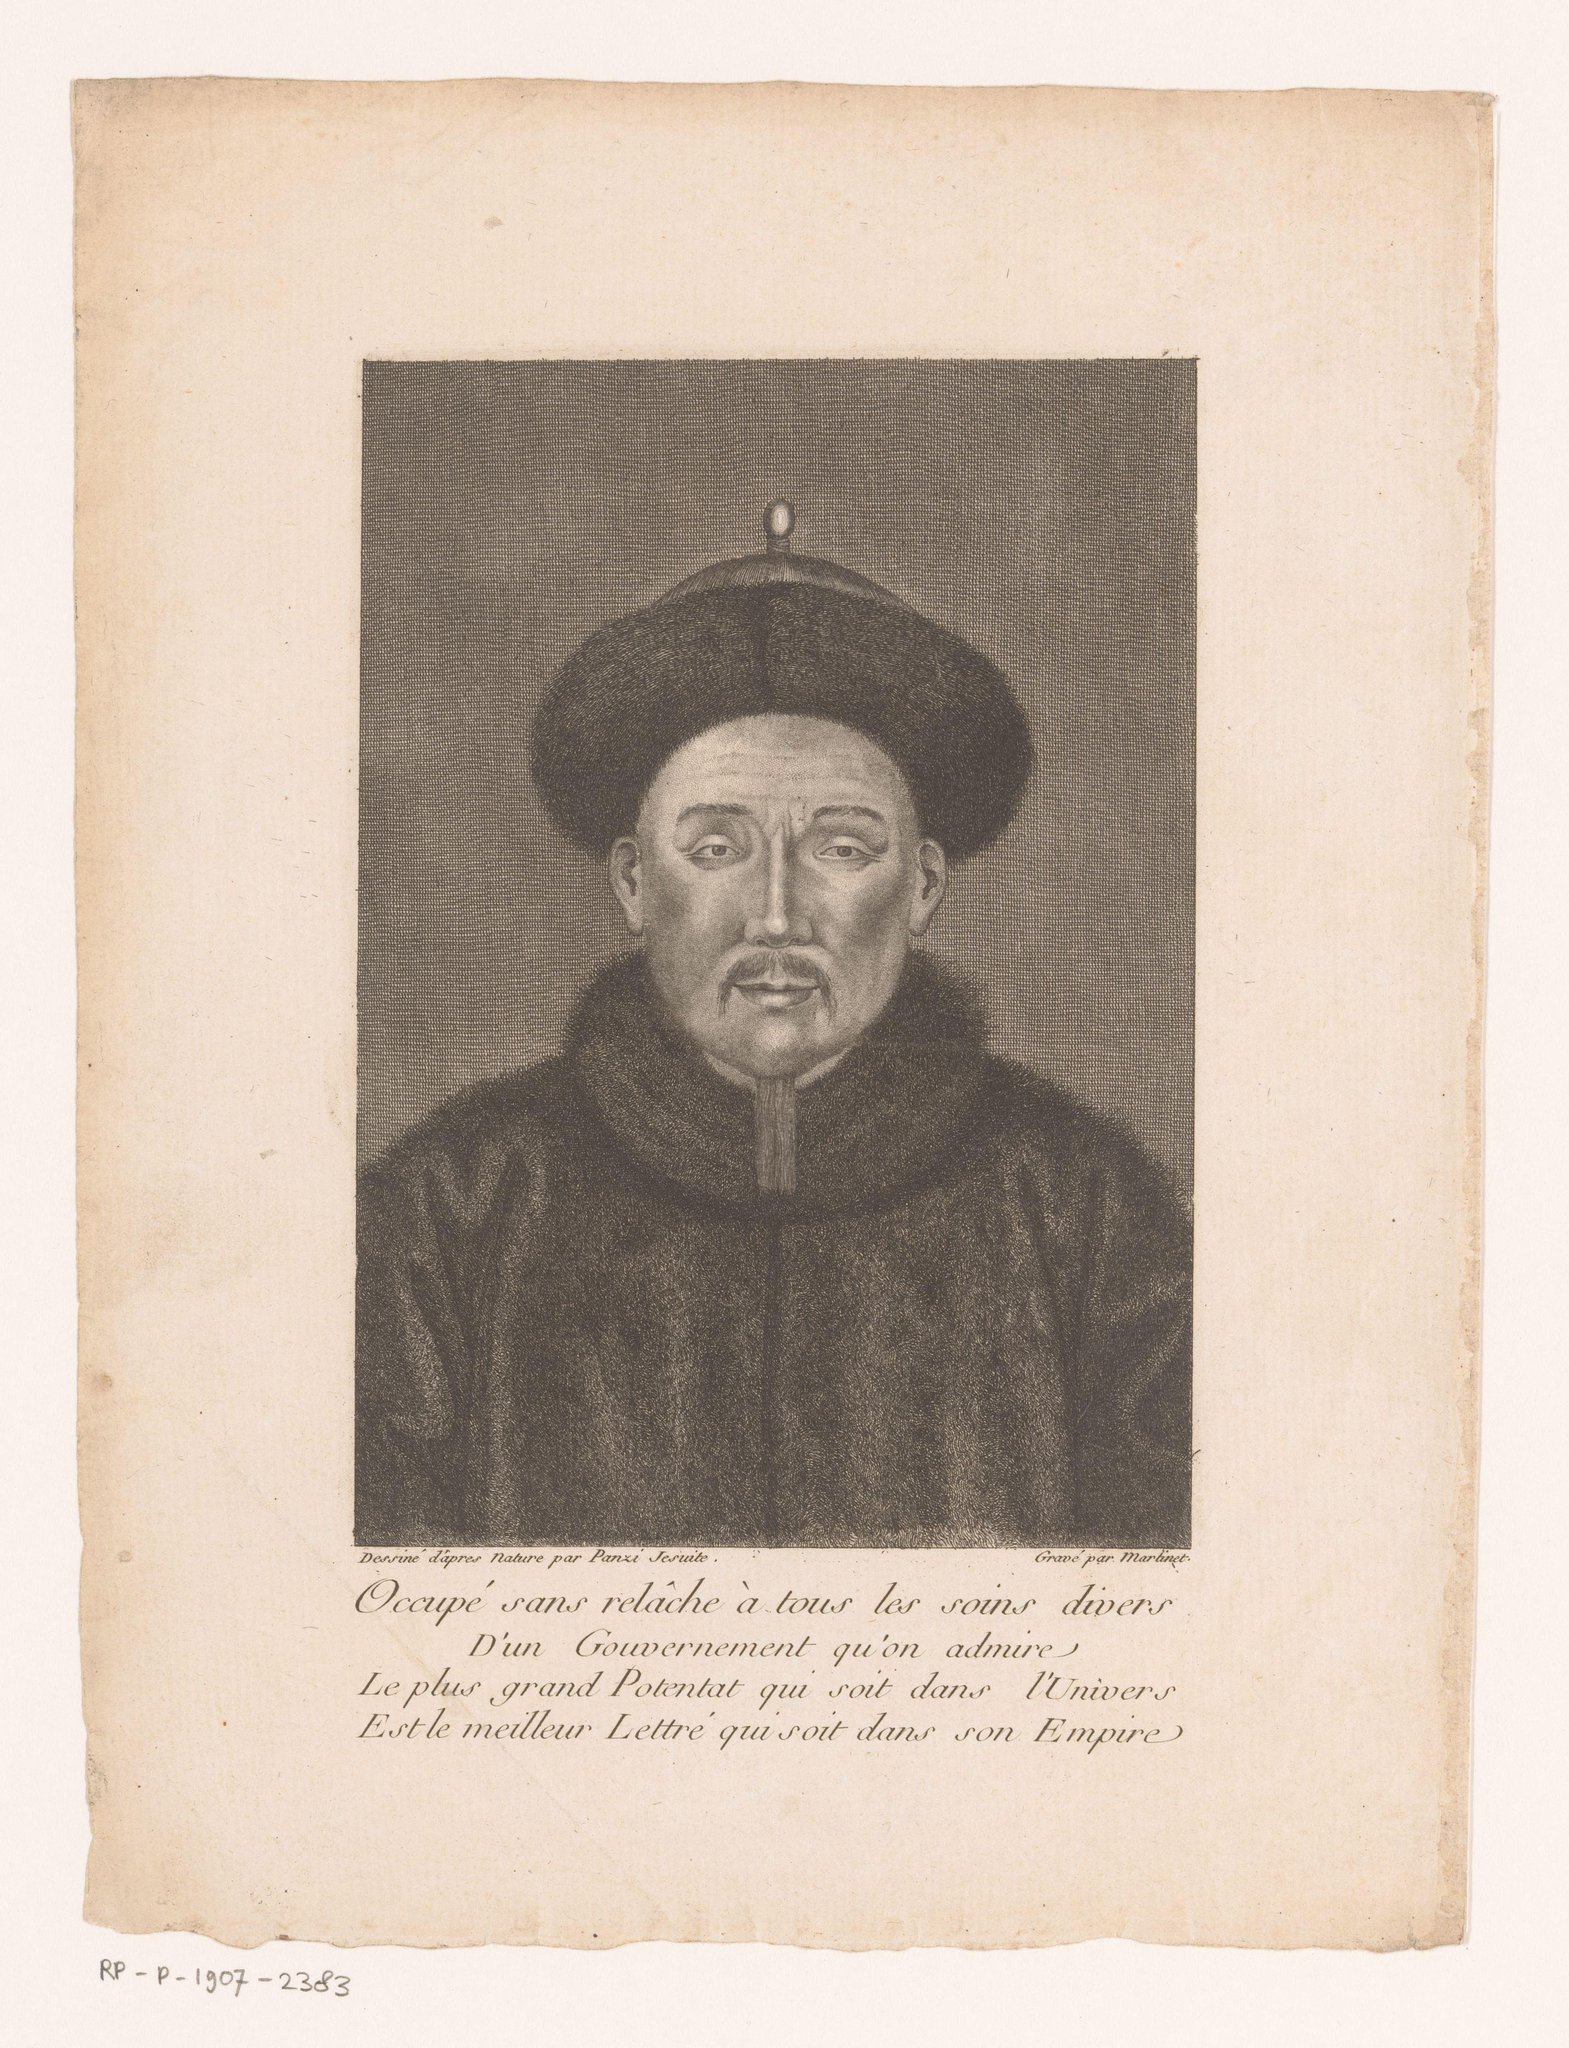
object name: print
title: Portret van de Chinese keizer Qianlong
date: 1741-1780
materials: paper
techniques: engraving, etching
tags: historical persons, emperor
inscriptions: collector's mark: Lugt 2228